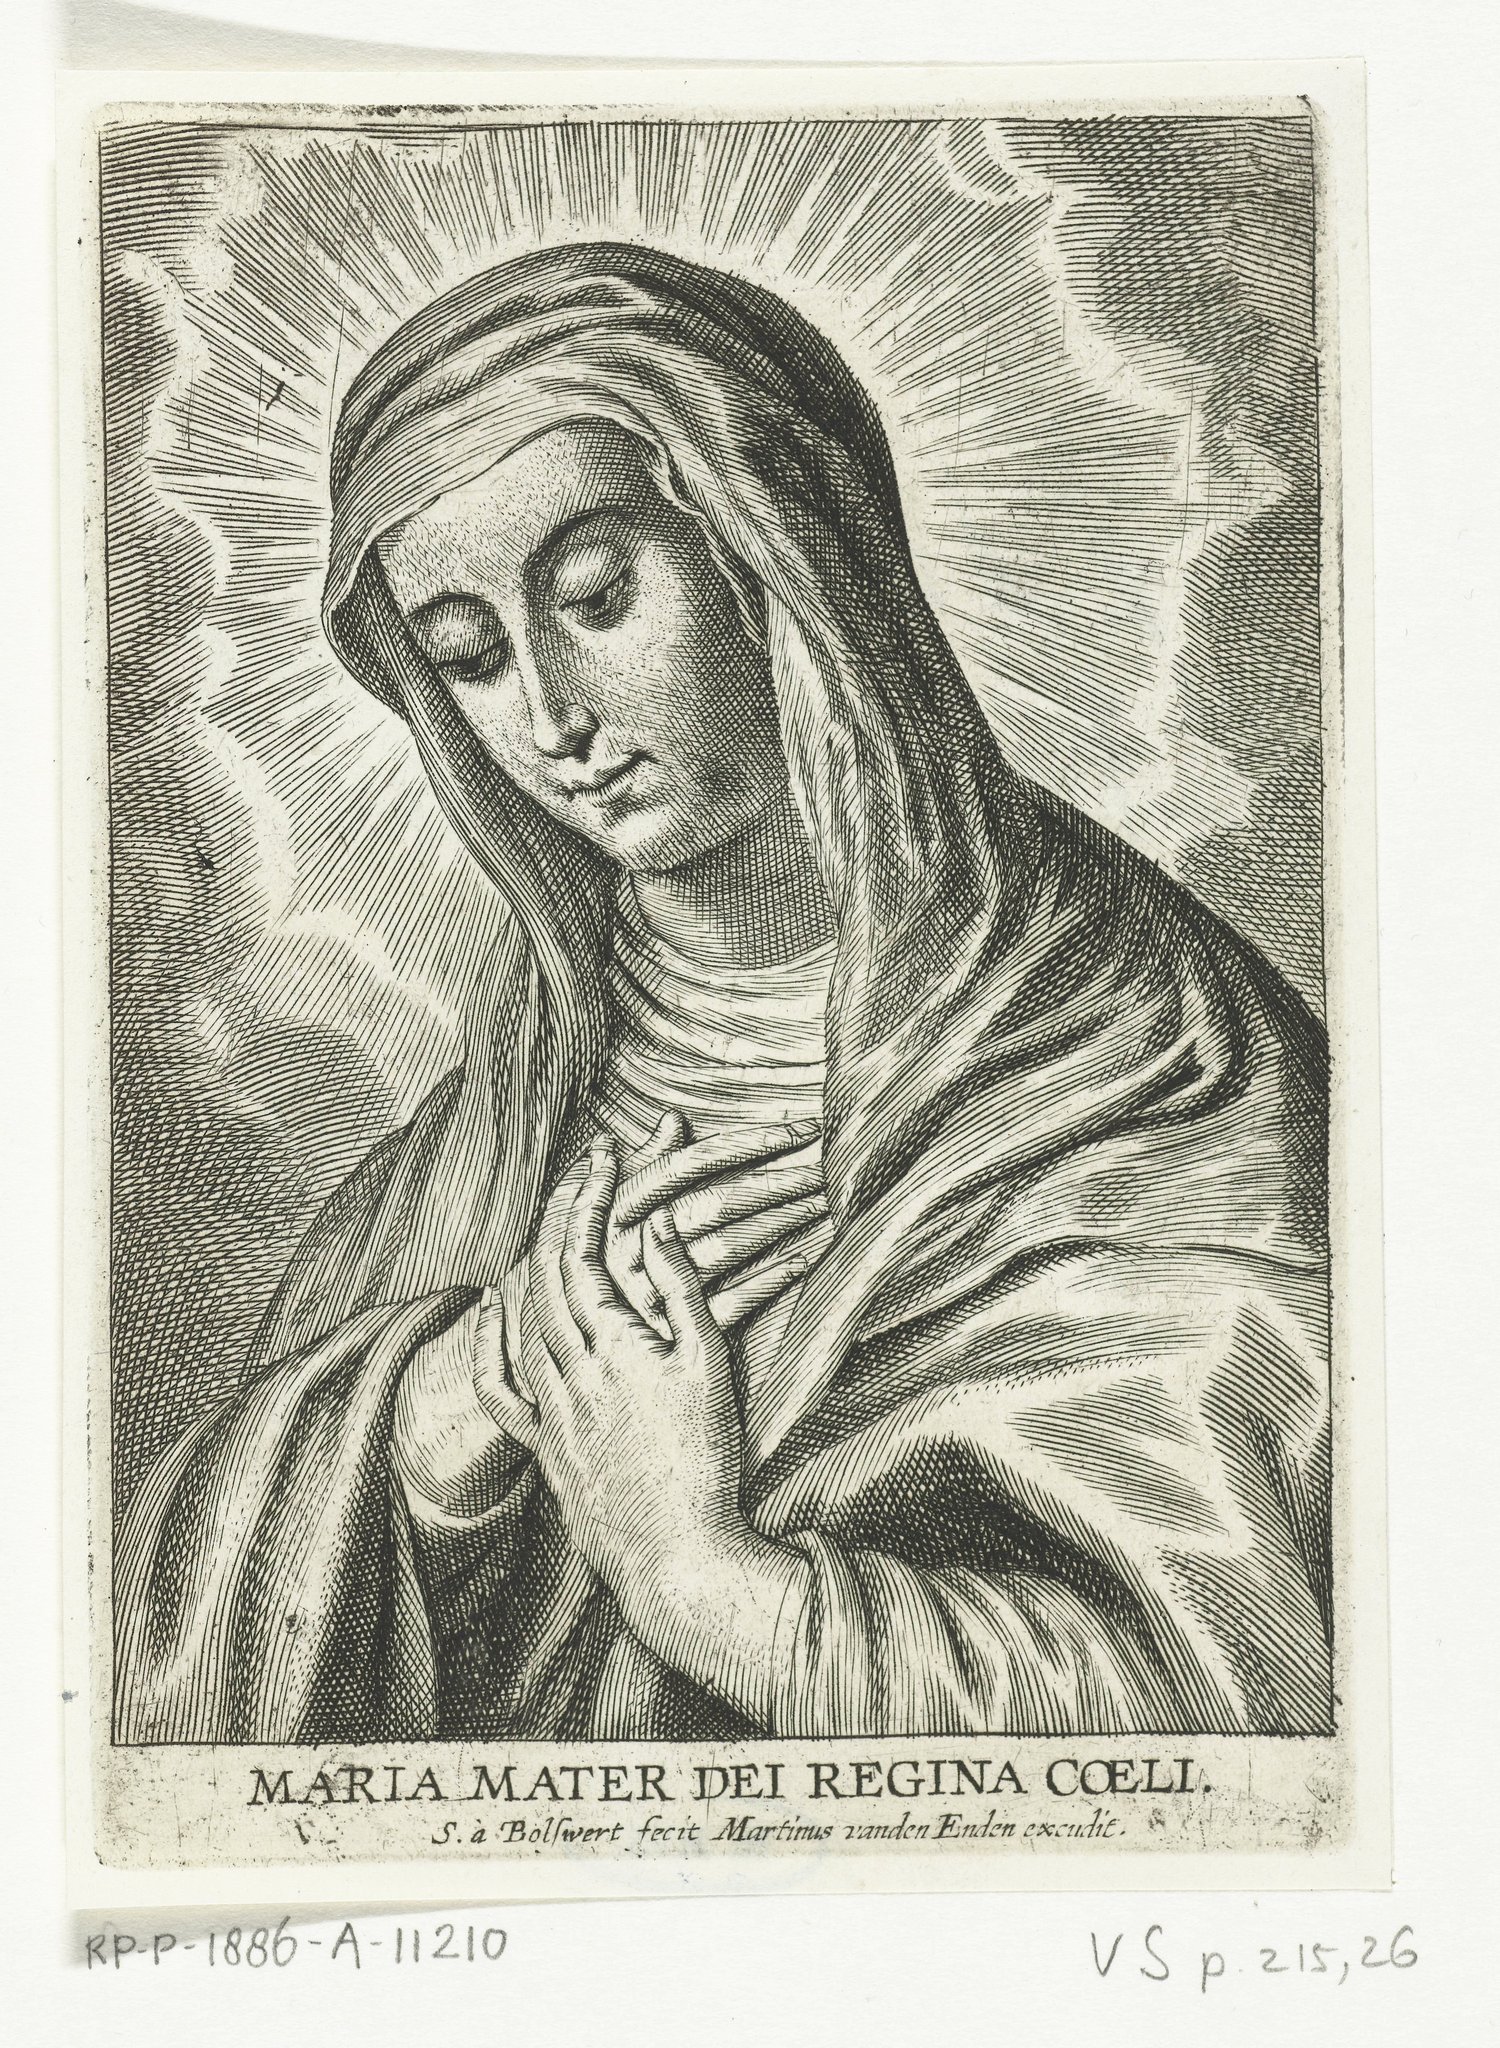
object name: print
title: Maria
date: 1596-1659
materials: paper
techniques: engraving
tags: mary (without the christ-child)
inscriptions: collector's mark: Lugt 2228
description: Prent uit serie Vélins met negentig prenten naar ontwerp van Peter Paul Rubens. In de bronnen vinden we uiteenlopende gegevens over aantal en samenstelling van de serie. Hollstein hanteert het aantal van negentig prenten. De reeks Vélins in de collectie van het RMA bevat verschillende staten afkomstig uit meerdere uitgaven welke moeilijk te duiden zijn. Sommige dragen het originele adres van Schelte Adamsz. Bolswert als graveur en uitgever, op andere exemplaren is deze naam verwijderd (duidelijk zichtbaar!) en vervangen door de naam Cornelis Galle (II). De prenten met de naam van uitgever Galle zijn vaak opgewerkt. We komen nog een andere naam van een uitgever onder enkele prenten tegen: Martien van den Enden. Herkomst uit meerdere uitgaven spreekt ook uit afwijkende opschriften in Nederlands en Latijn en variaties op dezelfde thema's welke misschien nooit langs elkaar in dezelfde serie gebruikt werden.